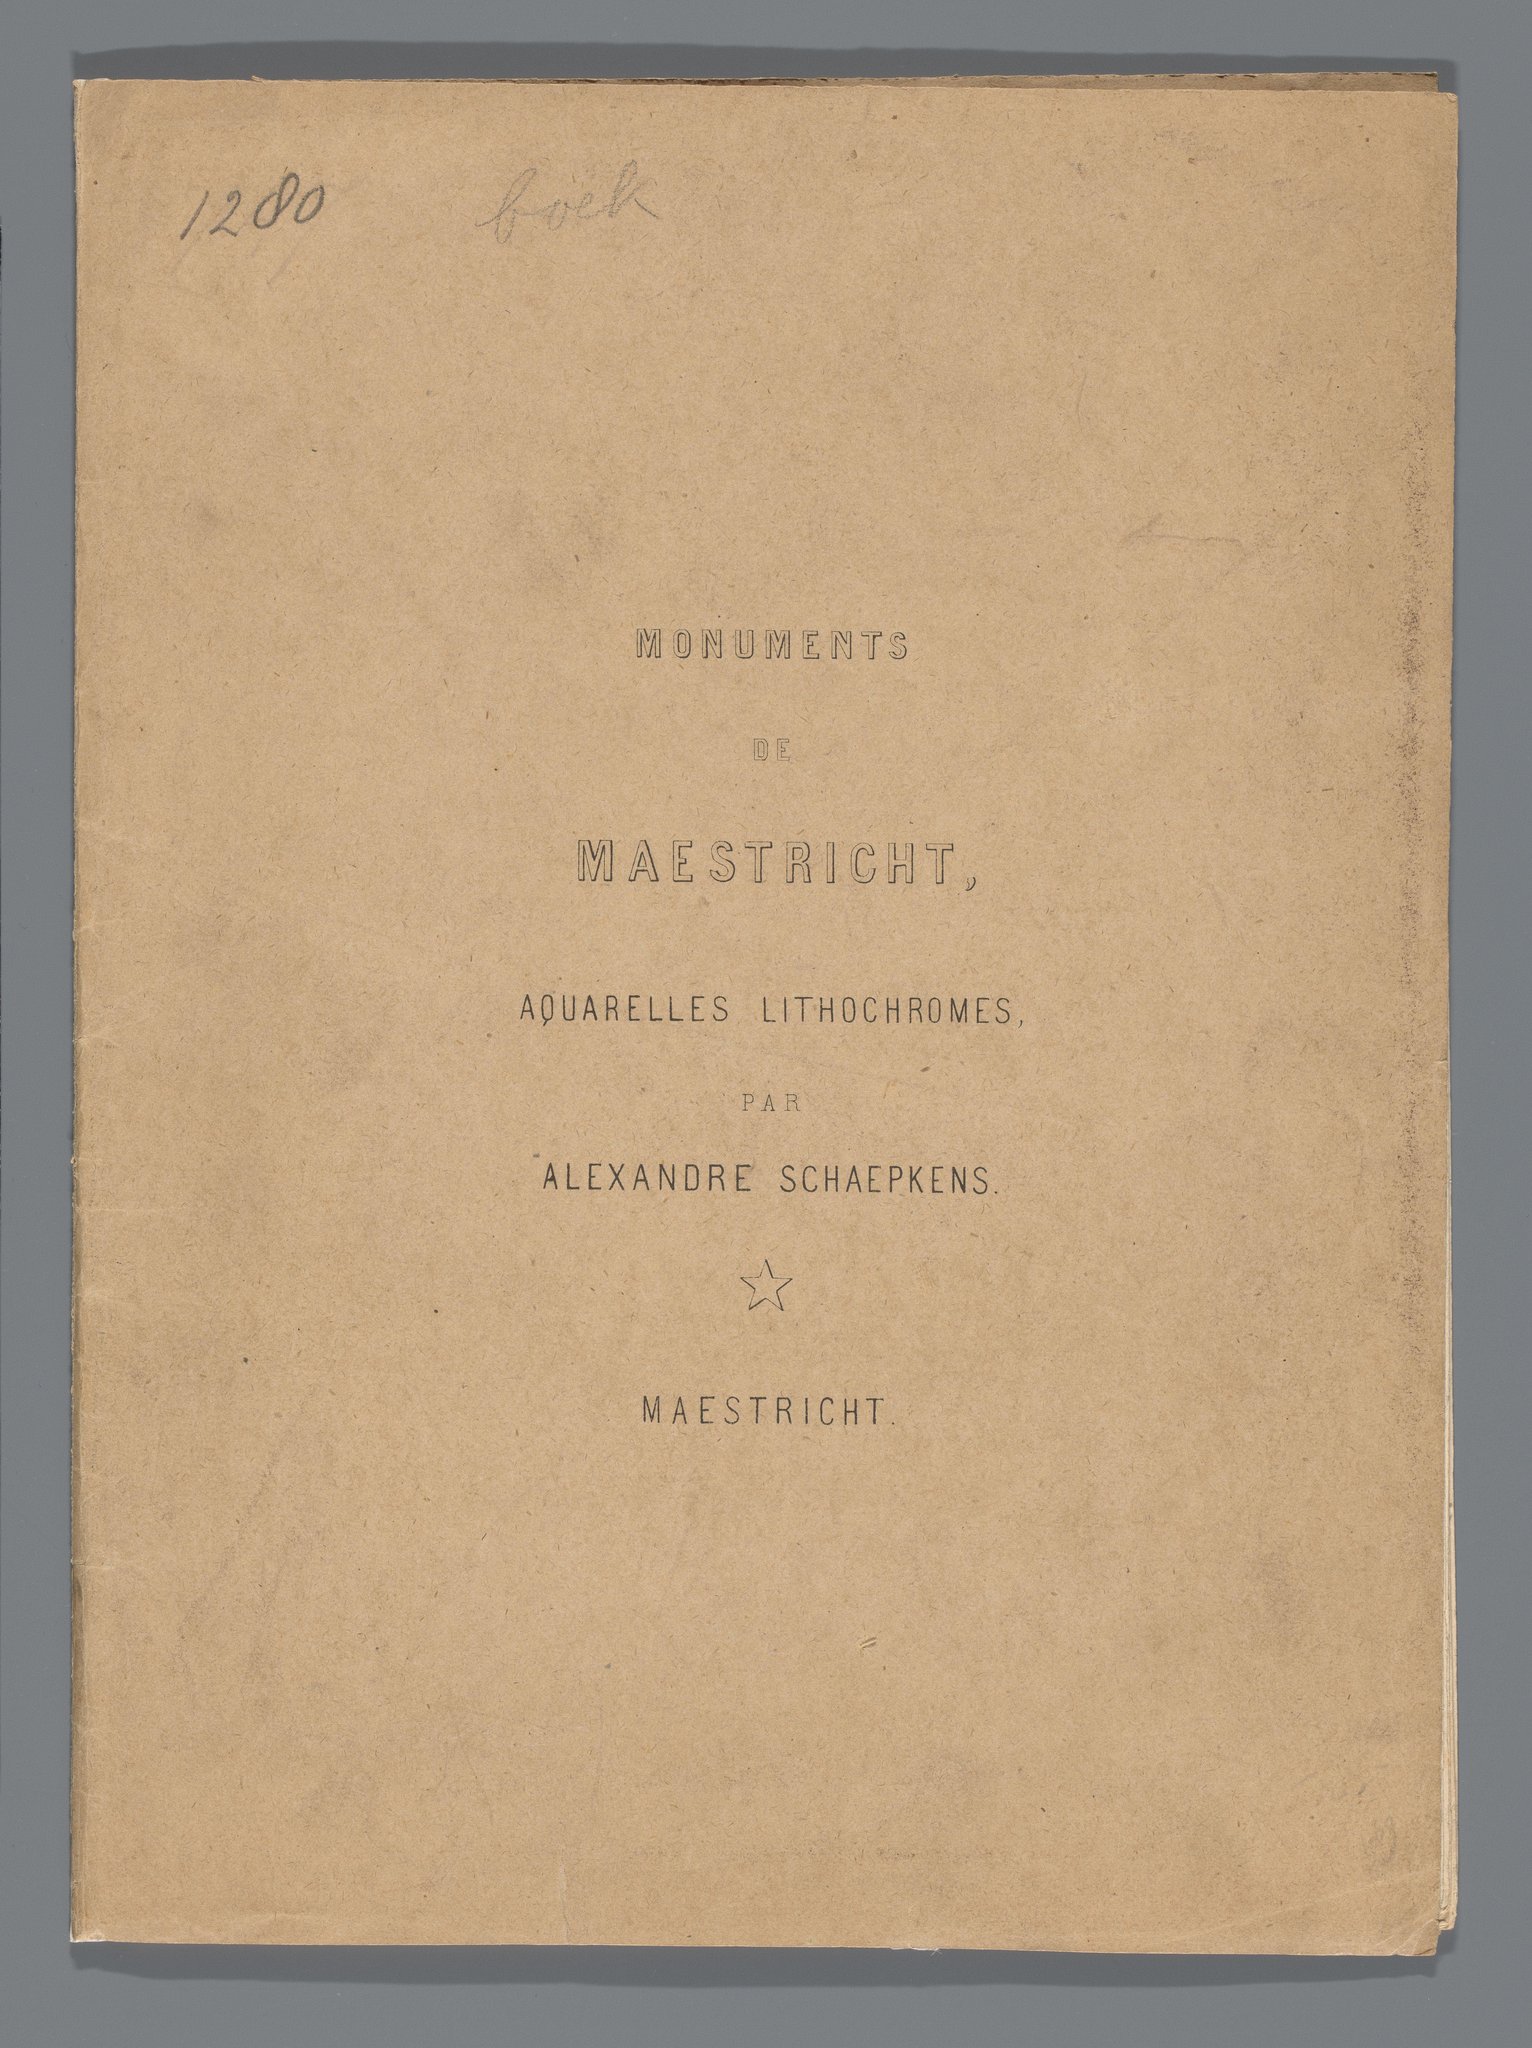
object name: print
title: Omslag met serie monumenten te Maastricht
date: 1857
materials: paper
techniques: lithograph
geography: brussels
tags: monument, statue, maastricht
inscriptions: collector's mark: Lugt 2166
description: Onderdeel van een omslag met een serie van tien lithografieën van monumenten te Maastricht.